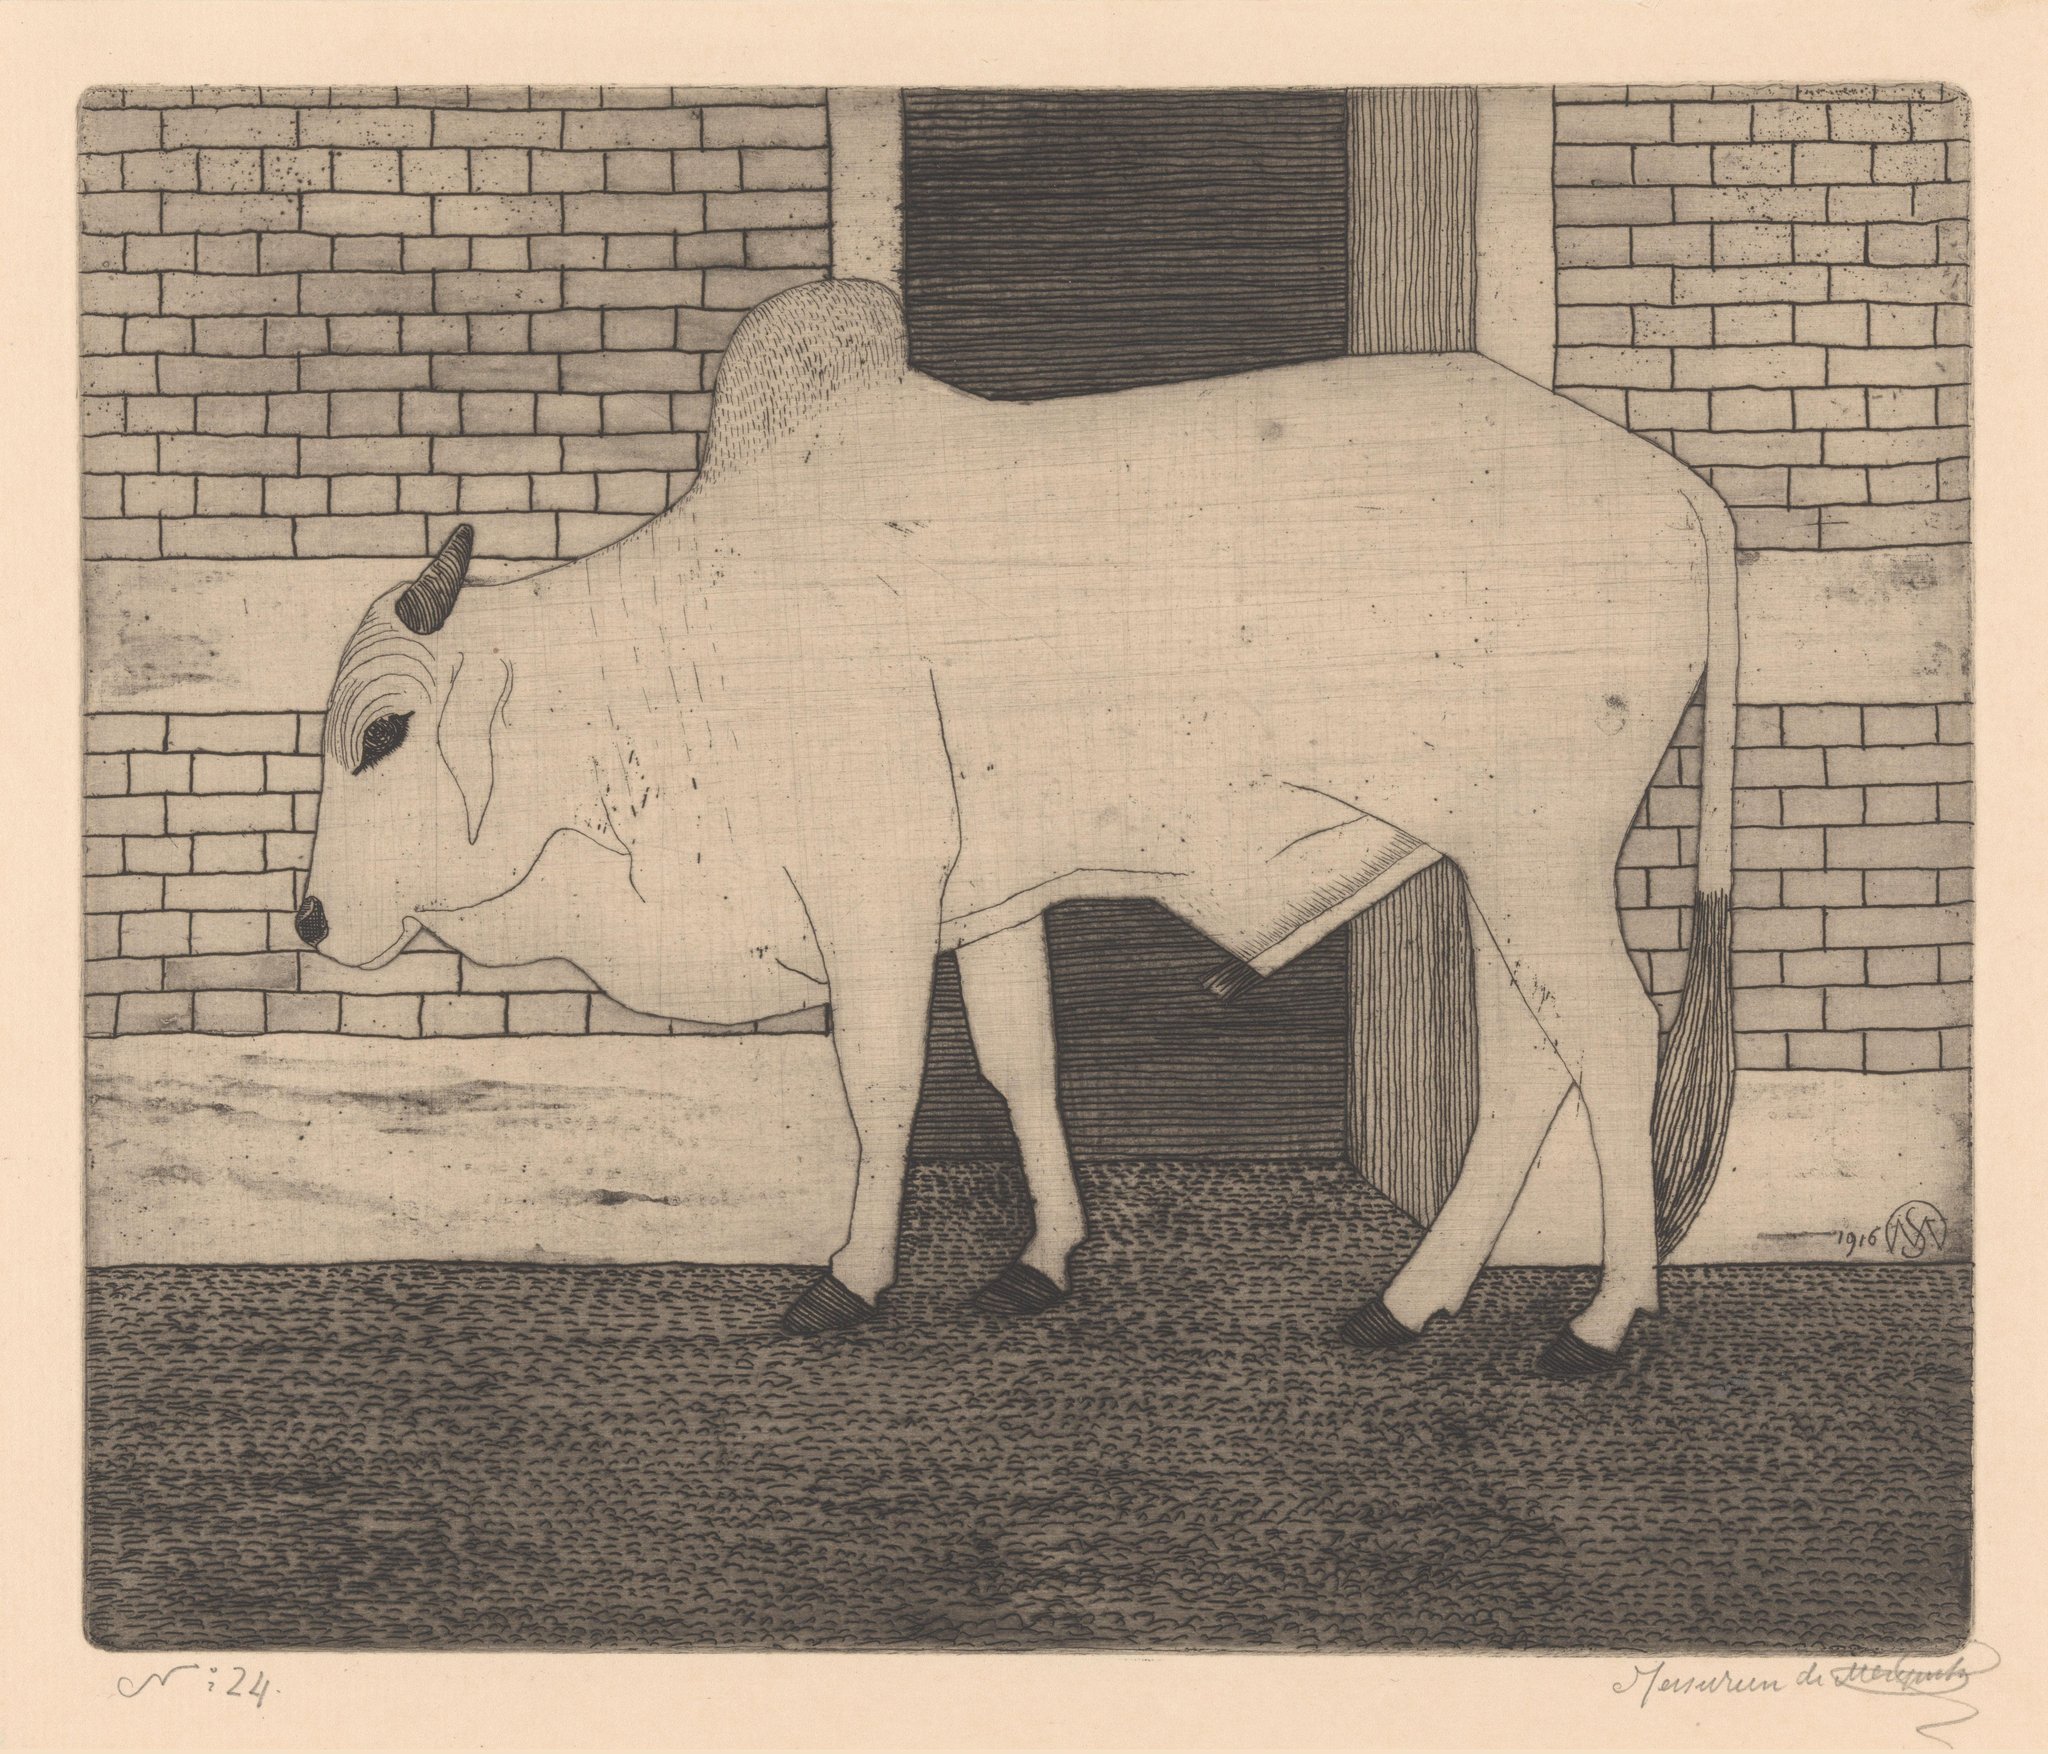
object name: print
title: Zebu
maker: samuel jessurun de mesquita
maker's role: draughtsman, print maker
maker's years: 1868-1944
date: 1916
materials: paper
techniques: aquatint, etching, intaglio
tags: cattle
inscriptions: number: ‘No 24’, collector's mark: Lugt 2228